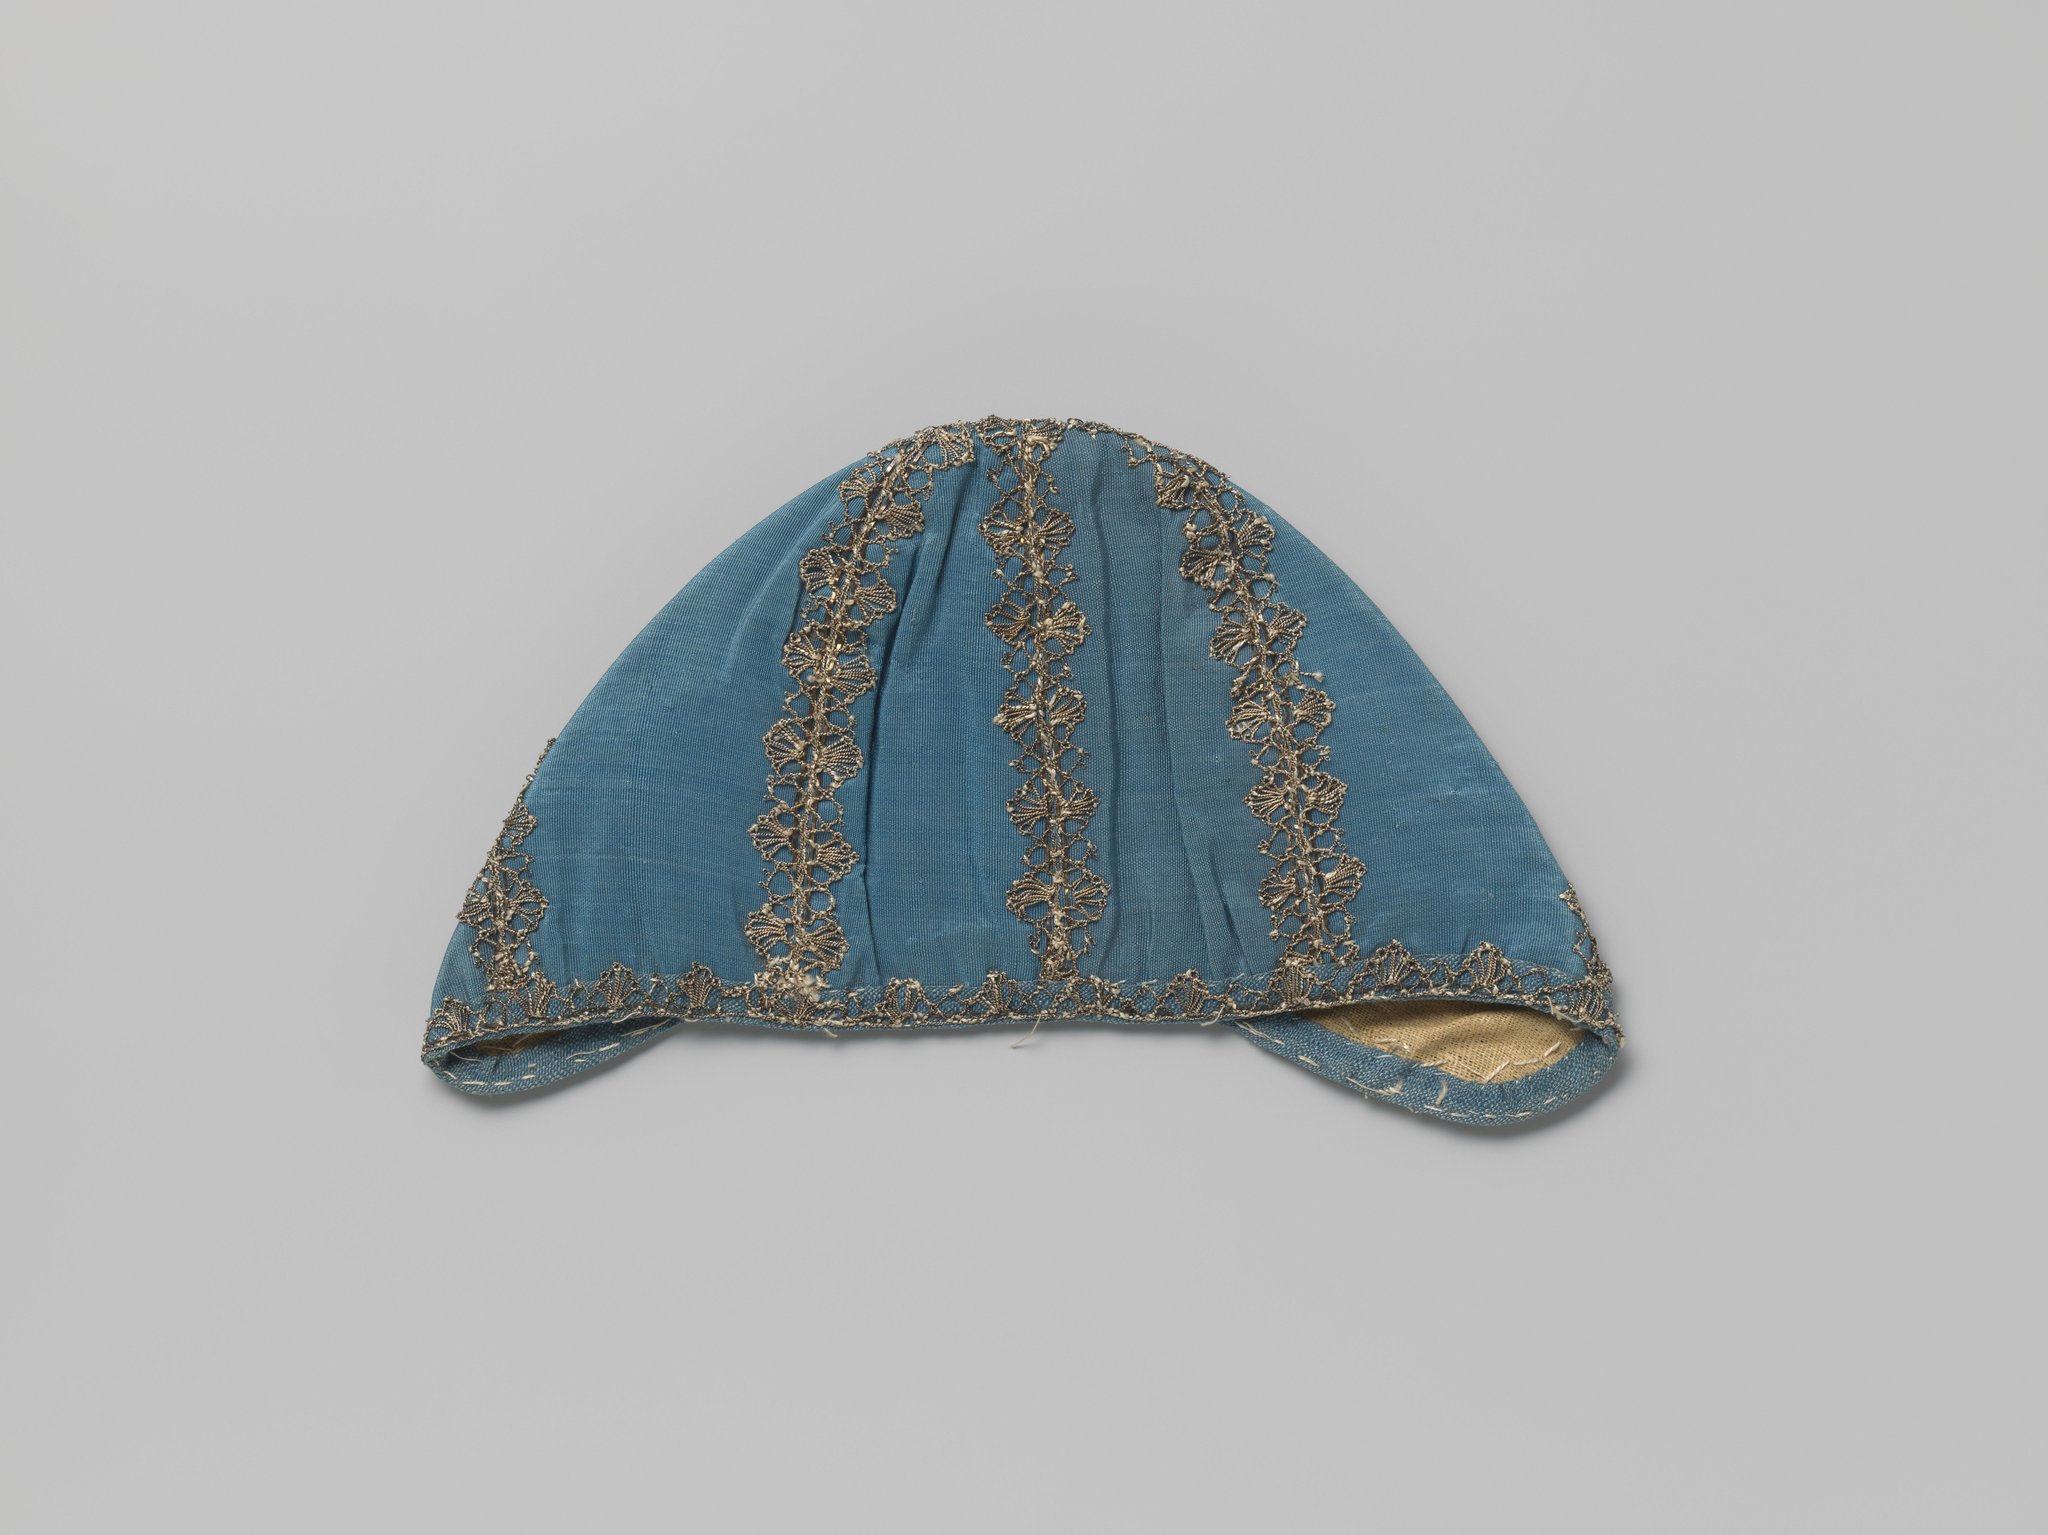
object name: cap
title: Muts van blauwe zijde met zilverdraad bestikt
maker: Anonymous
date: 1785-1800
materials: silk, thread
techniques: stitching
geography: europe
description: Mutsje van blauwe zijde met zilverderaad bestikt.